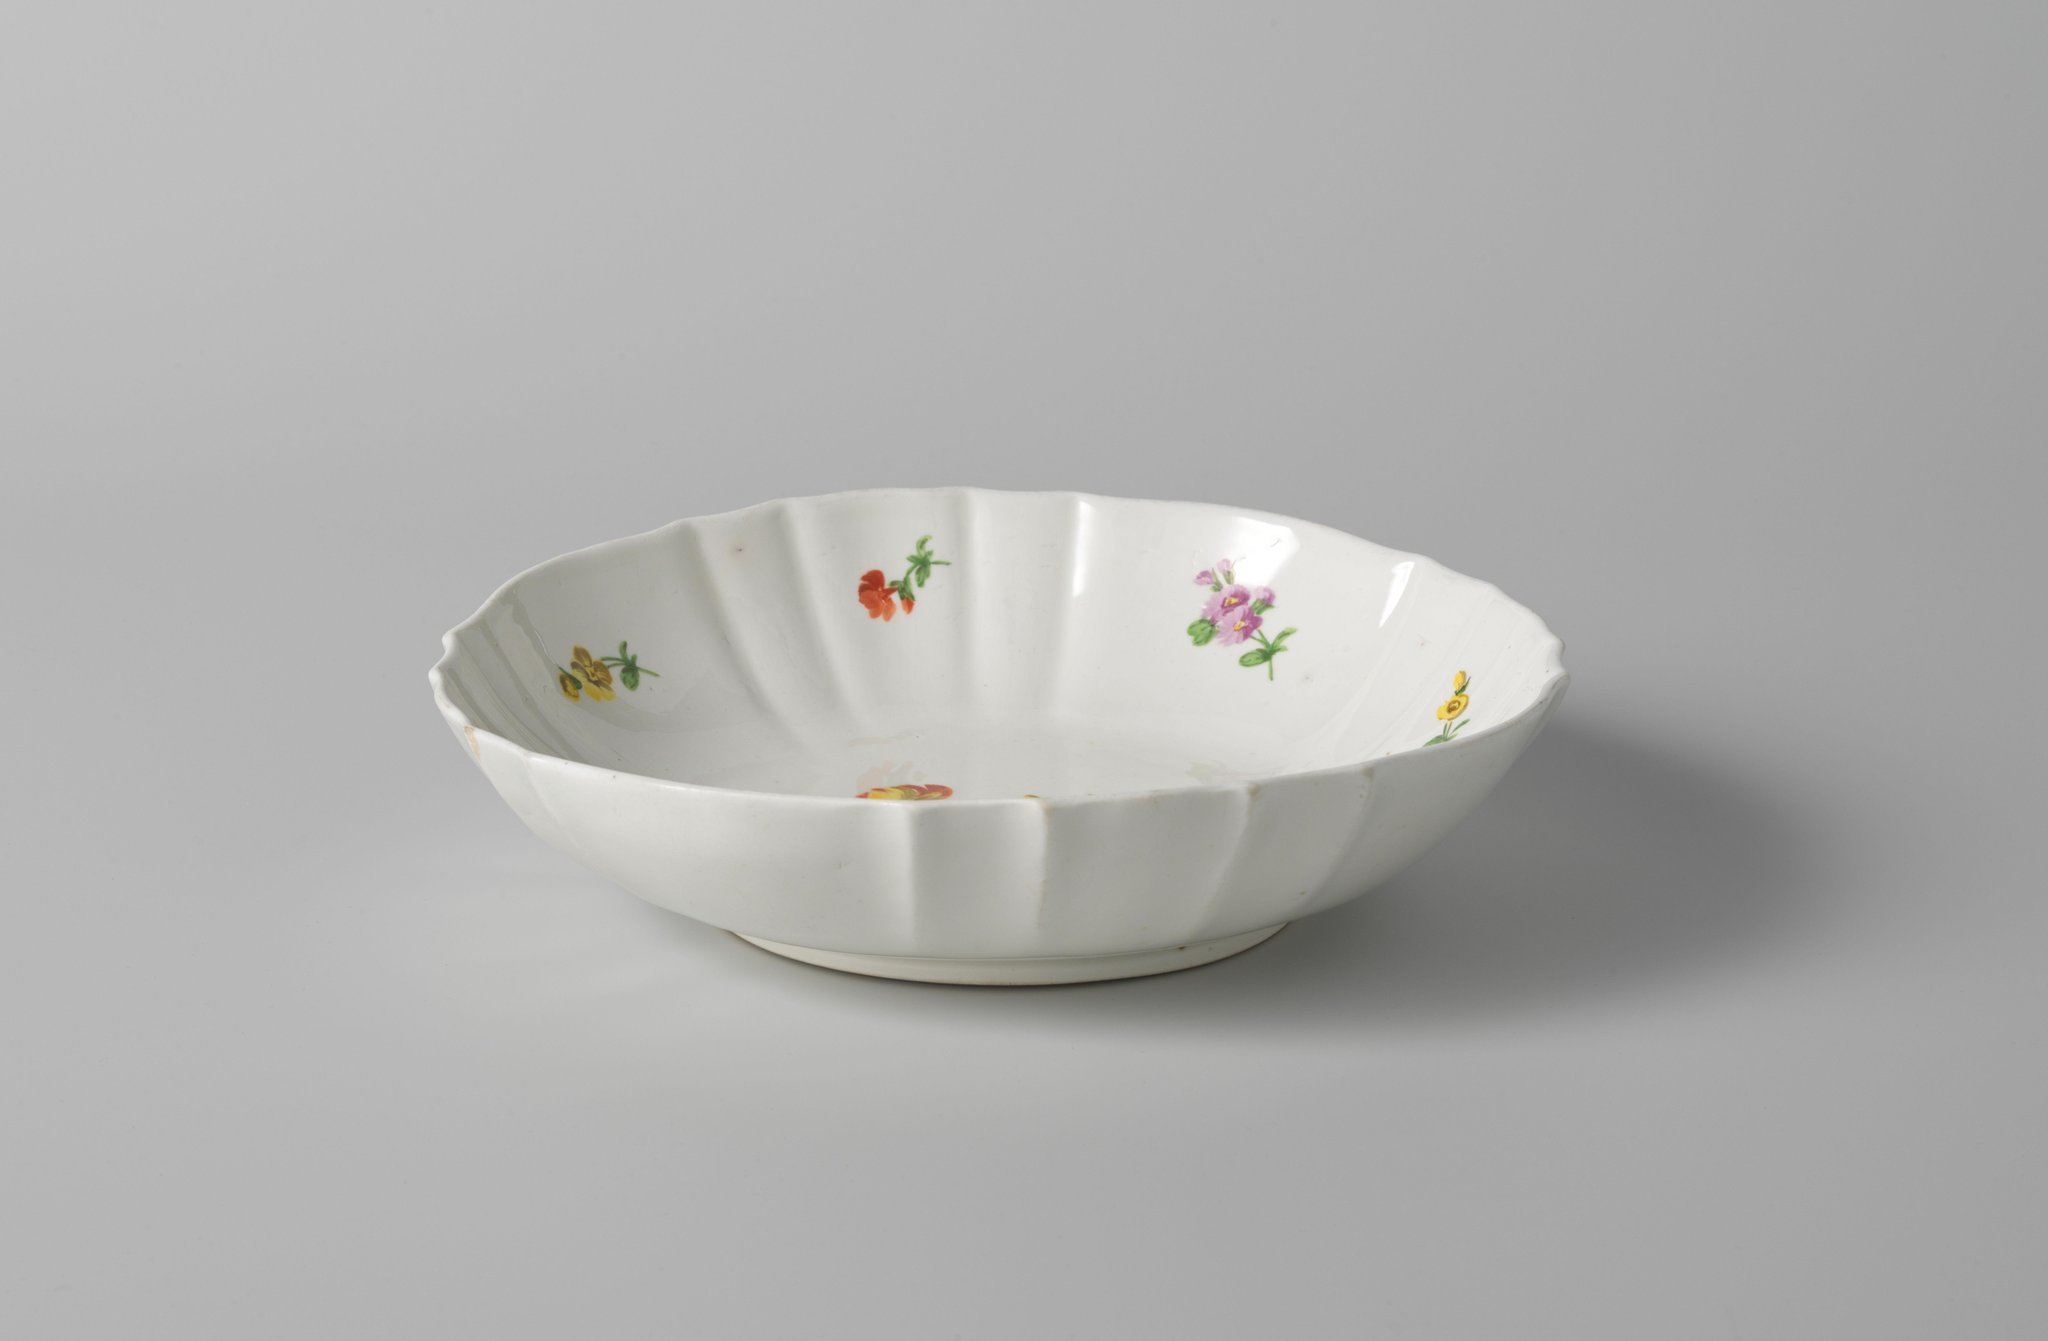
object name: dish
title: Dish with a bouquet and flower sprays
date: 1800-1849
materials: glaze, paint, porcelain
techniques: firing, forming, turning, vitrification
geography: vienna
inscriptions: mark: ‘schild’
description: Schaal van porselein met geschulpte wand en rand, beschilderd op het glazuur in rood, roze, groen en geel. Op het plat een boeket van verschillende bloemen (o.a. pioenroos) en op de binnenwand acht bloemtakken. Gemerkt op de onderzijde met het schild.